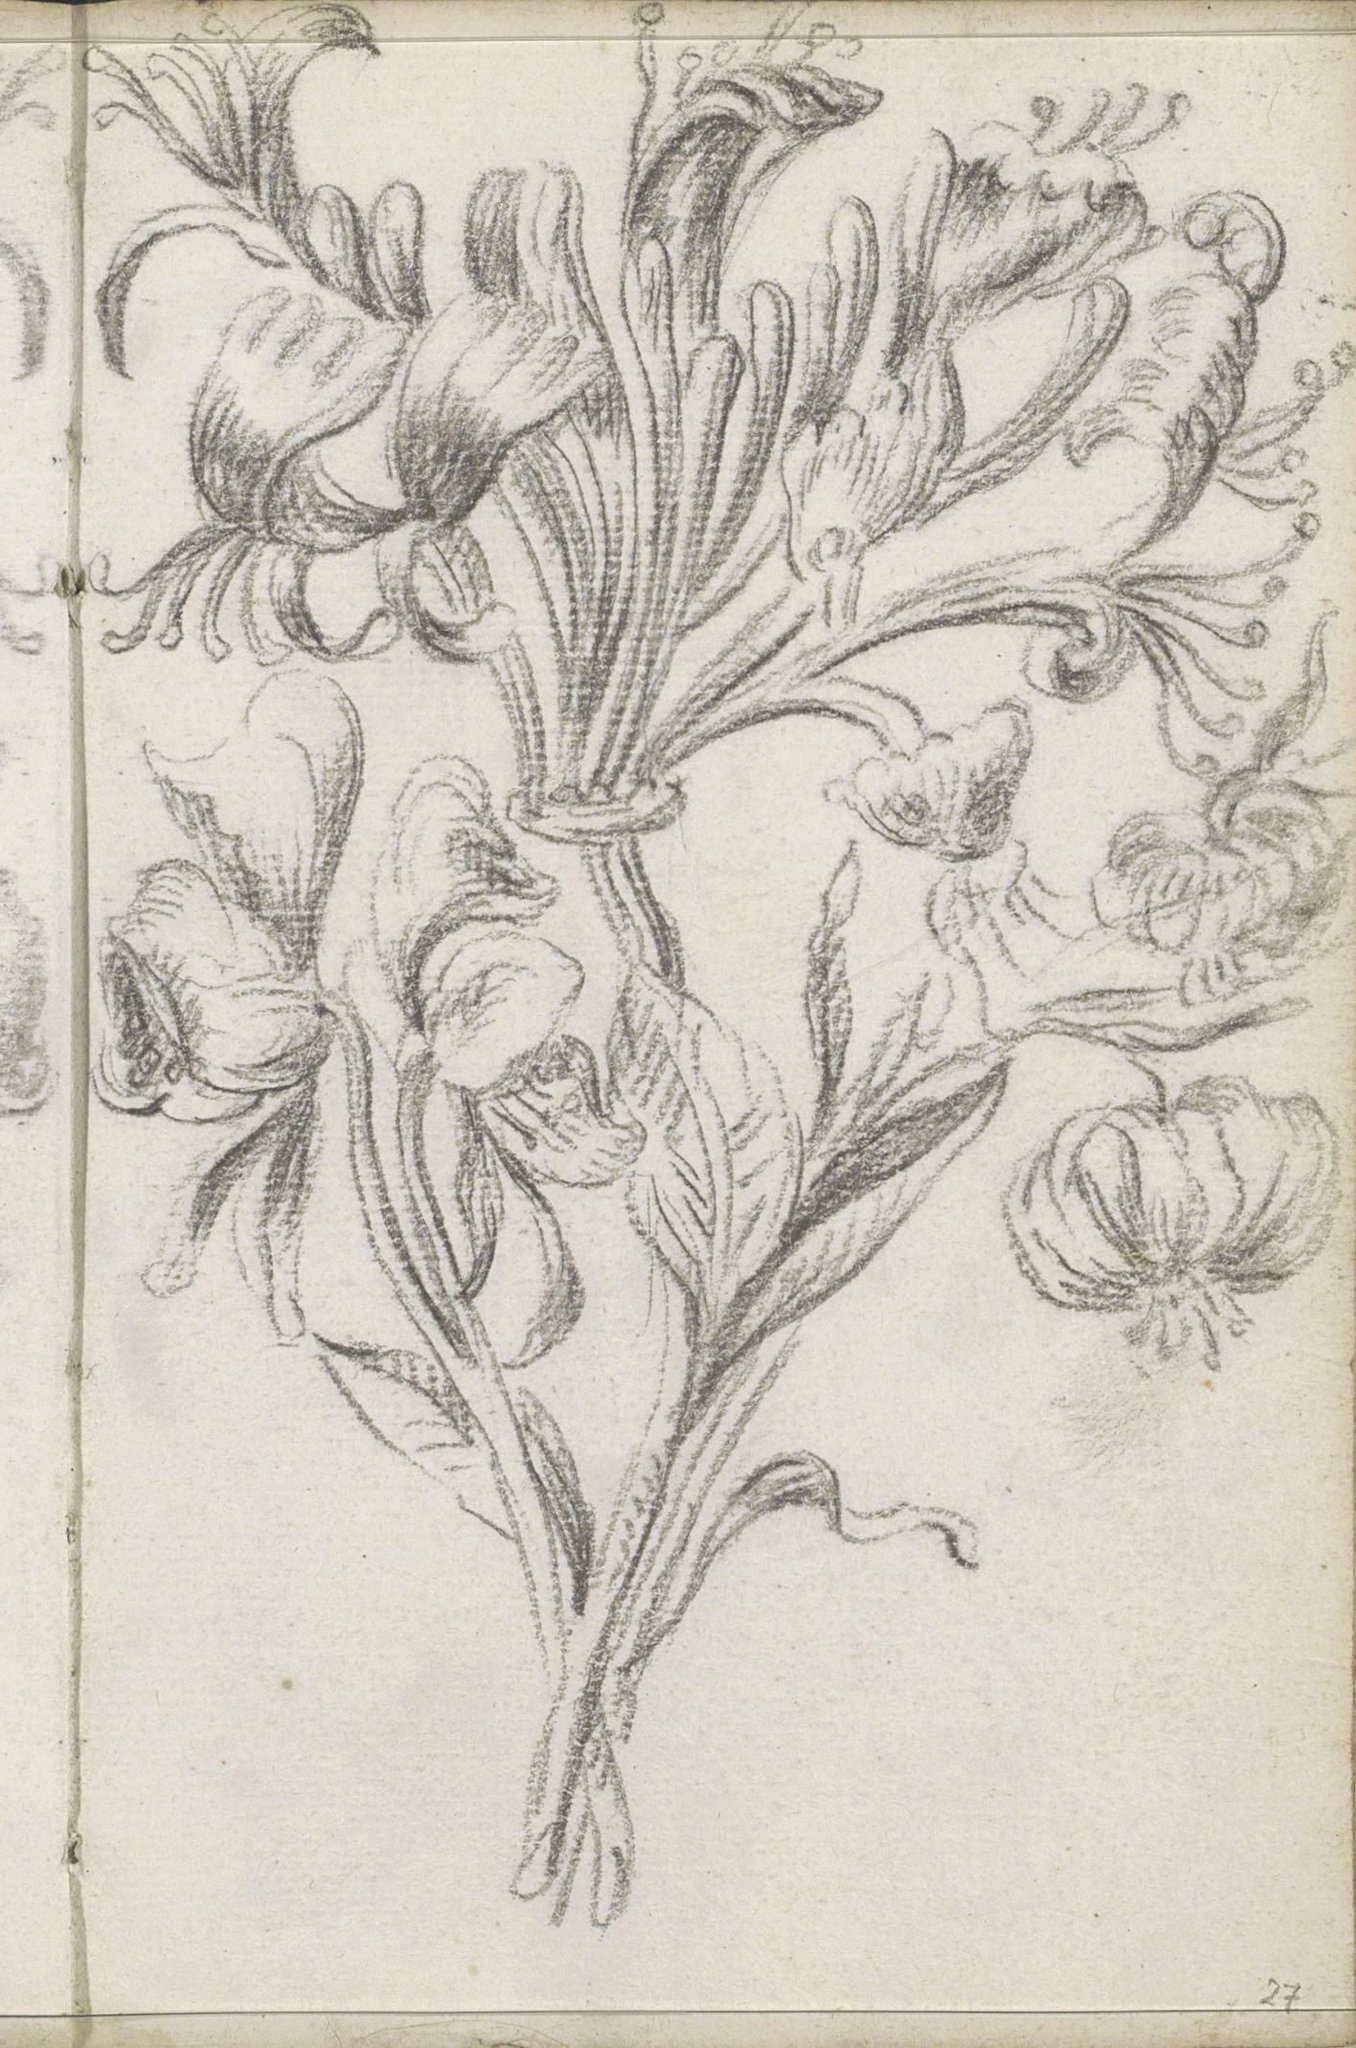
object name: sketchbook leaf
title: Boeket met bloemen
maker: petrus johannes van reysschoot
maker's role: draughtsman, print maker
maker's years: 1702-1772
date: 1710-1772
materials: chalk, paper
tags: cut flowers; nosegay, bunch of flowers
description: Blad 27 recto uit een schetsboek met 105 bladen.